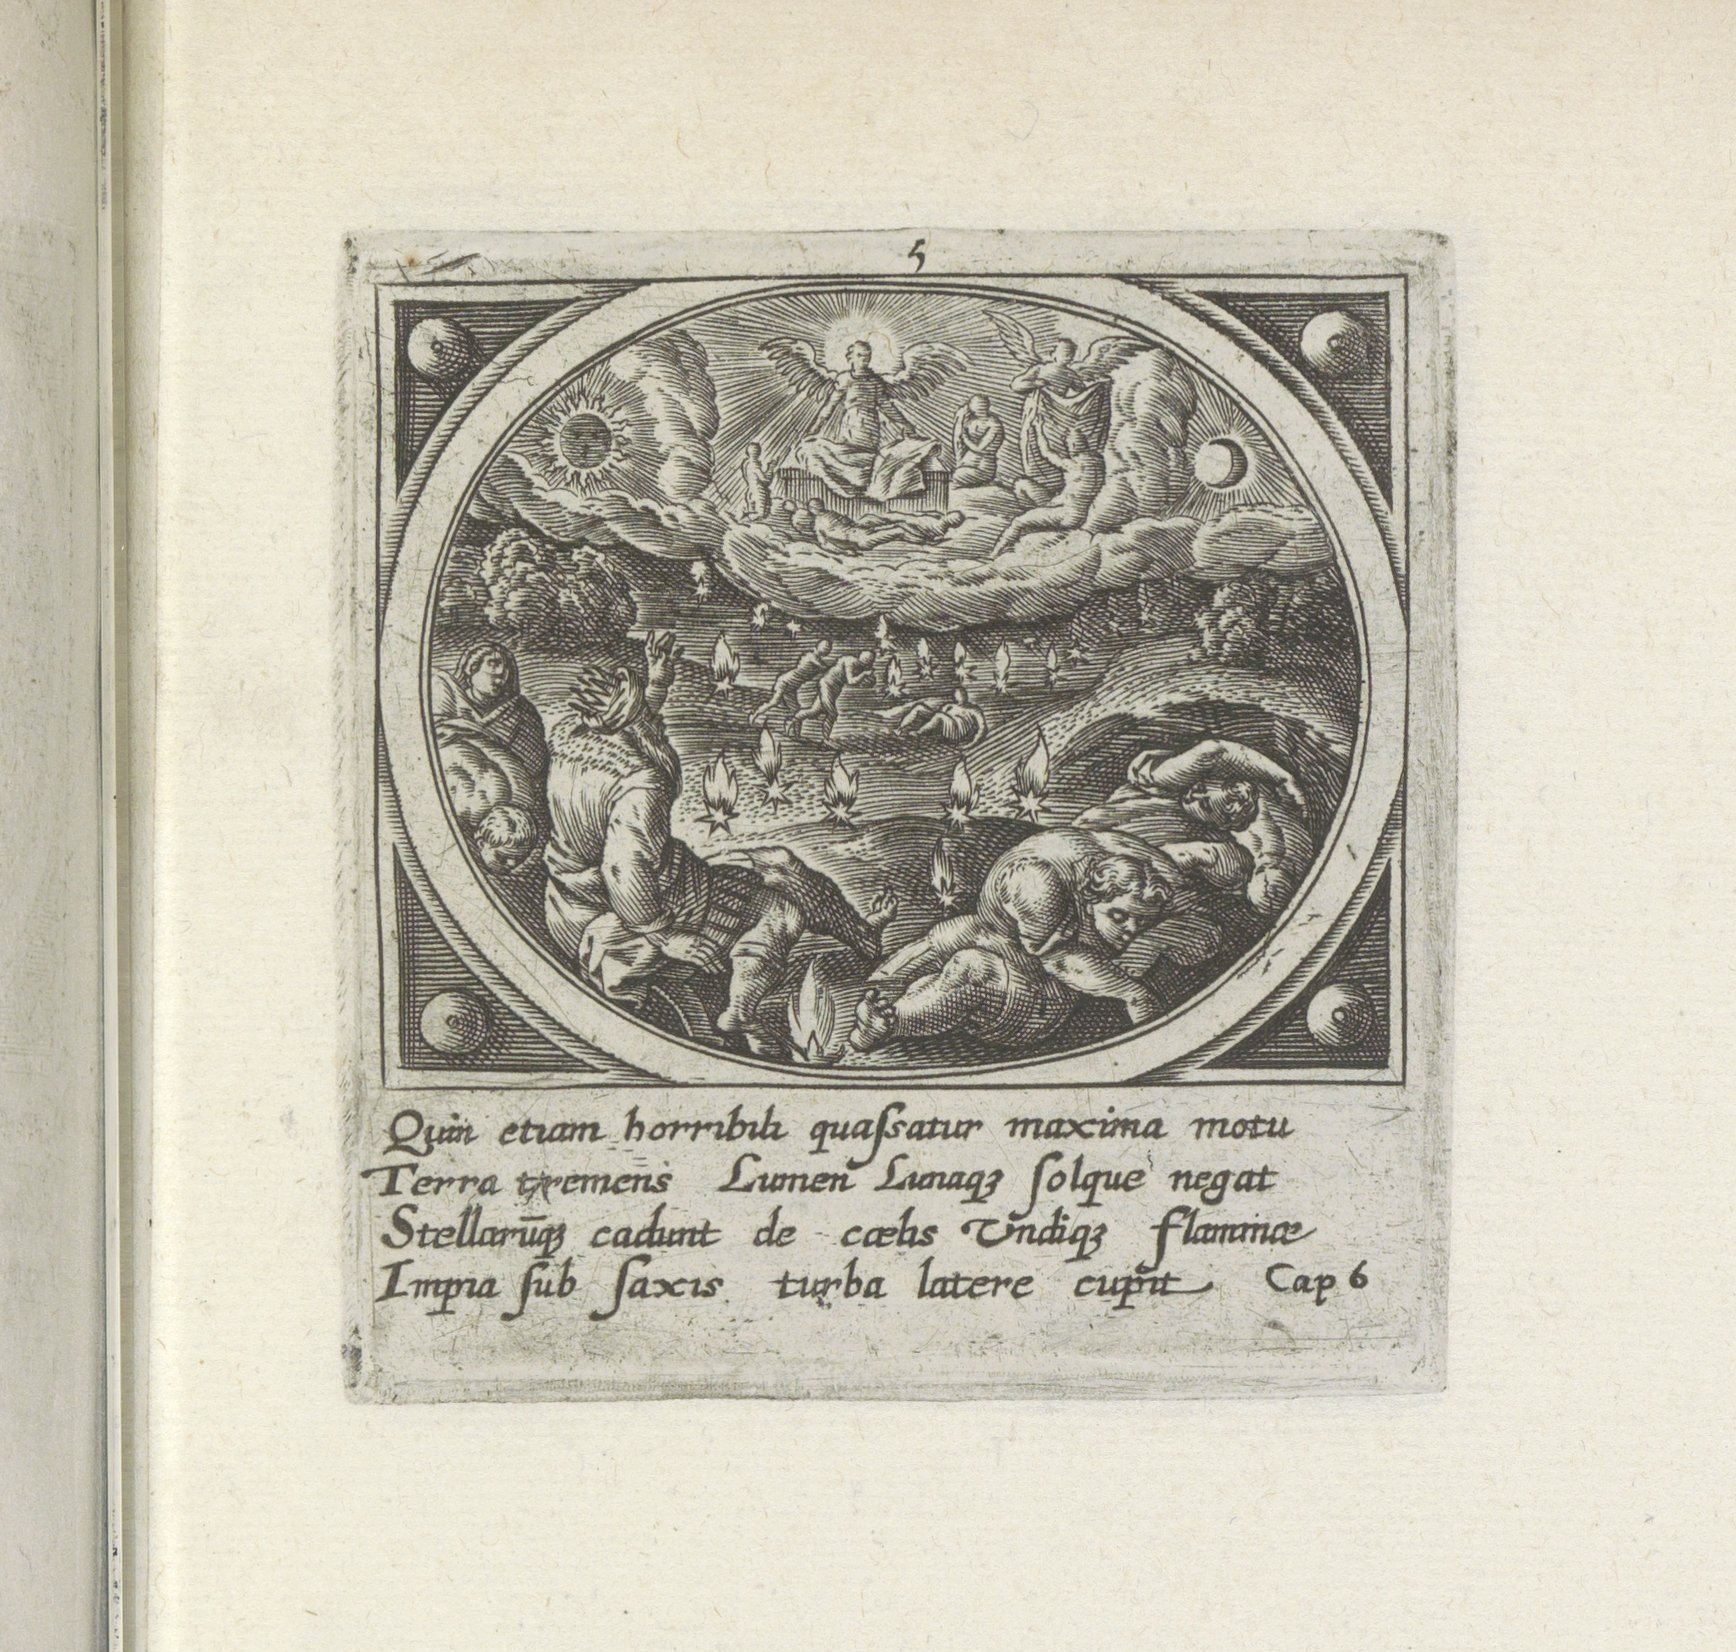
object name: album leaf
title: Icones Revelationum S Iohs Evangeliste in Pathmo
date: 1585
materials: paper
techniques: engraving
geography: antwerp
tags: opening of the sixth seal: a great earthquake, the sun turns black, the moon red as blood, and the stars fall on earth; mankind hiding in caves, opening of the fifth seal: white robes are given to (the souls of) the martyrs under the altar (+ angel(s) floating in the air)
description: Het openen van het vijfde zegel: bij een altaar staan de zielen, die allen witte kleren ontvangen. Daaronder het openen van het zesde zegel: brandende sterren vallen op aarde na een aardbeving. Onder de voorstelling een verwijzing in het Latijn naar de Bijbeltekst in Op. 6. Deze prent maakt deel uit van een album.